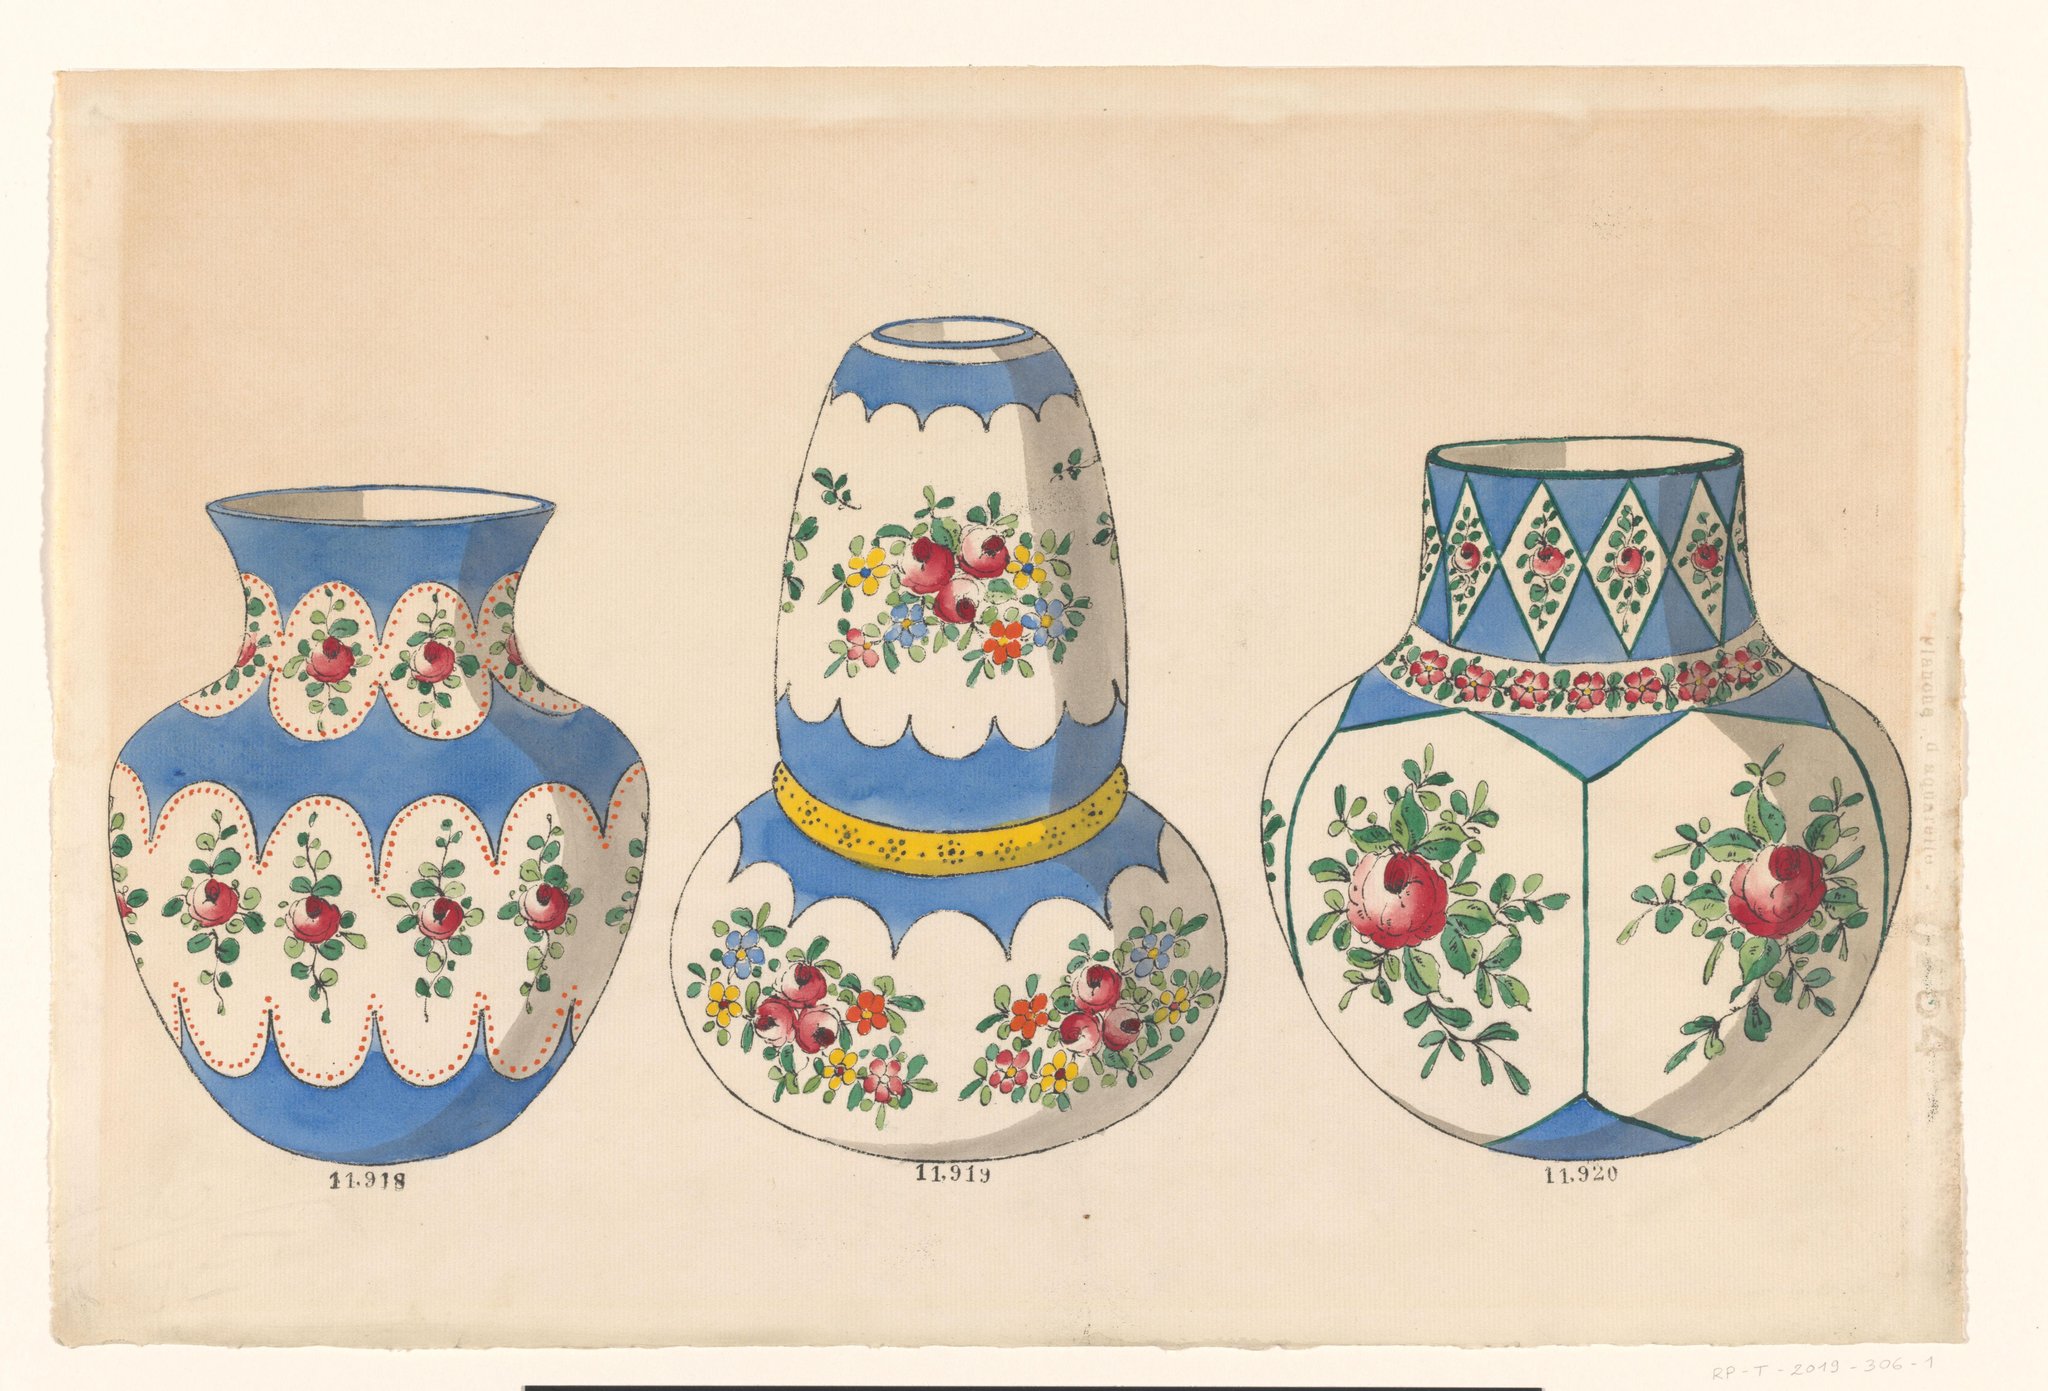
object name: drawing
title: Zes bladen uit een produktiecatalogus van een ceramiekmanufactuur of -handelaar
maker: Anonymous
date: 1900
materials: ink, paper, watercolor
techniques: brush, pen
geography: france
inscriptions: stamp: ‘Planche d'aquarelle 0454’, watermark: ‘MBM’, stamp